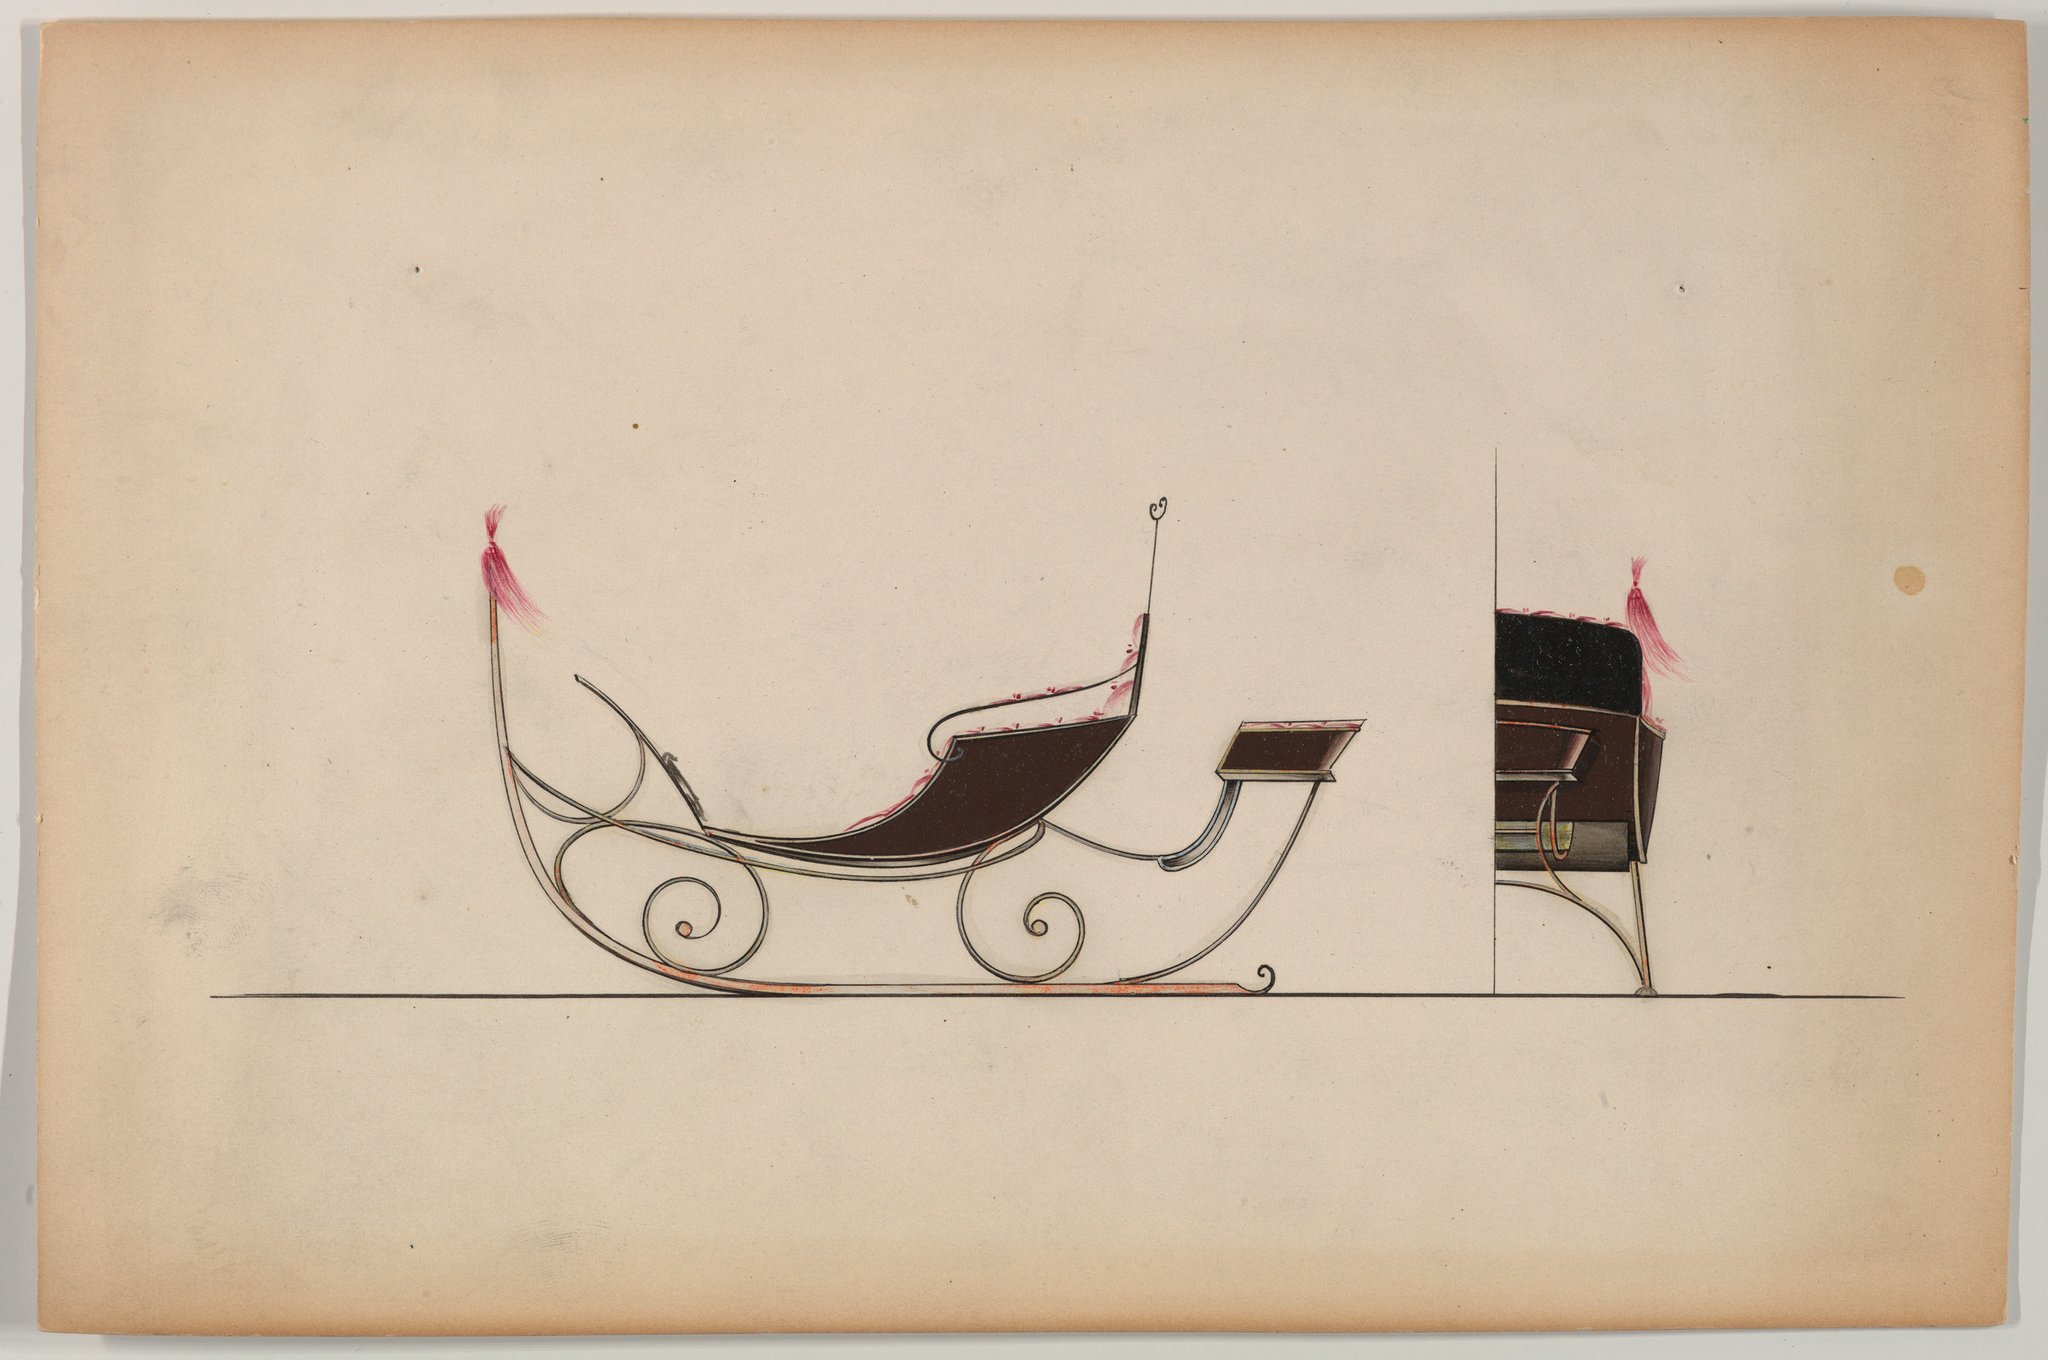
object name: drawing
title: Sleigh with rumble seat (unnumbered)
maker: brewster & co.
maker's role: manufacturer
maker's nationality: american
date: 1875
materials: gouache, gum arabic, ink, watercolor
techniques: pen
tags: carriages